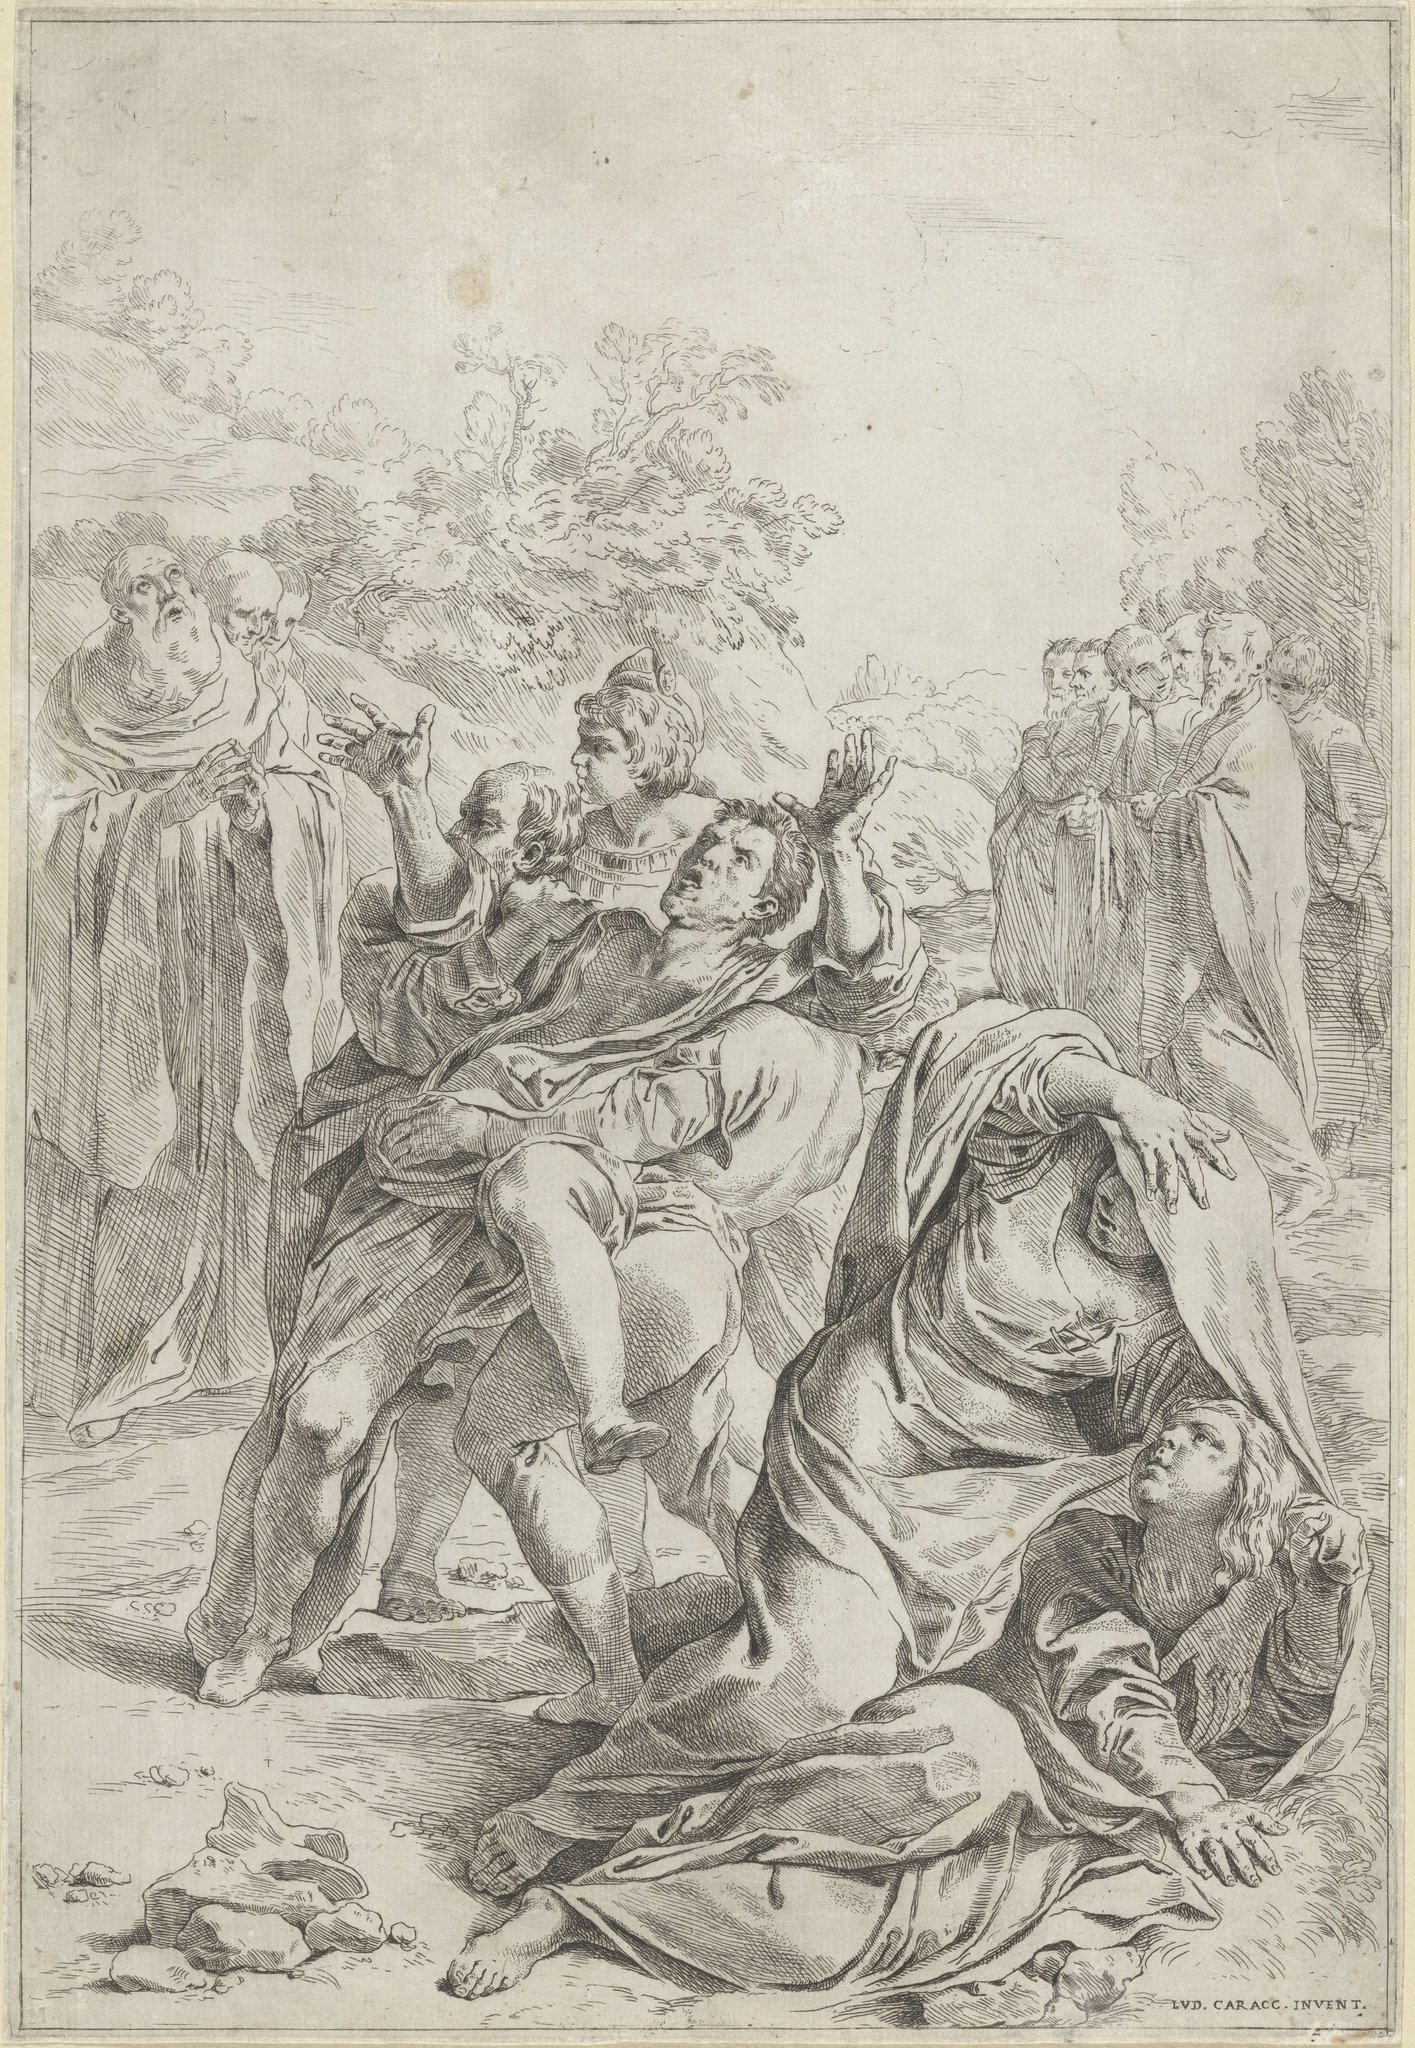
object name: print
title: Heilige Benedictus drijft een demon uit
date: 1622-1648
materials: paper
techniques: etching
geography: bologna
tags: st. benedict exorcizing the devil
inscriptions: collector's mark: ‘M’ Lugt 1842, collector's mark: Lugt 240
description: Een wild spartelende, door demonen bezeten, man wordt door twee mannen vastgehouden. Op de achtergrond links staat de heilige Benedictus, bijgestaan door twee mannen. Op de voorgrond rechts duiken twee vrouwen weg.